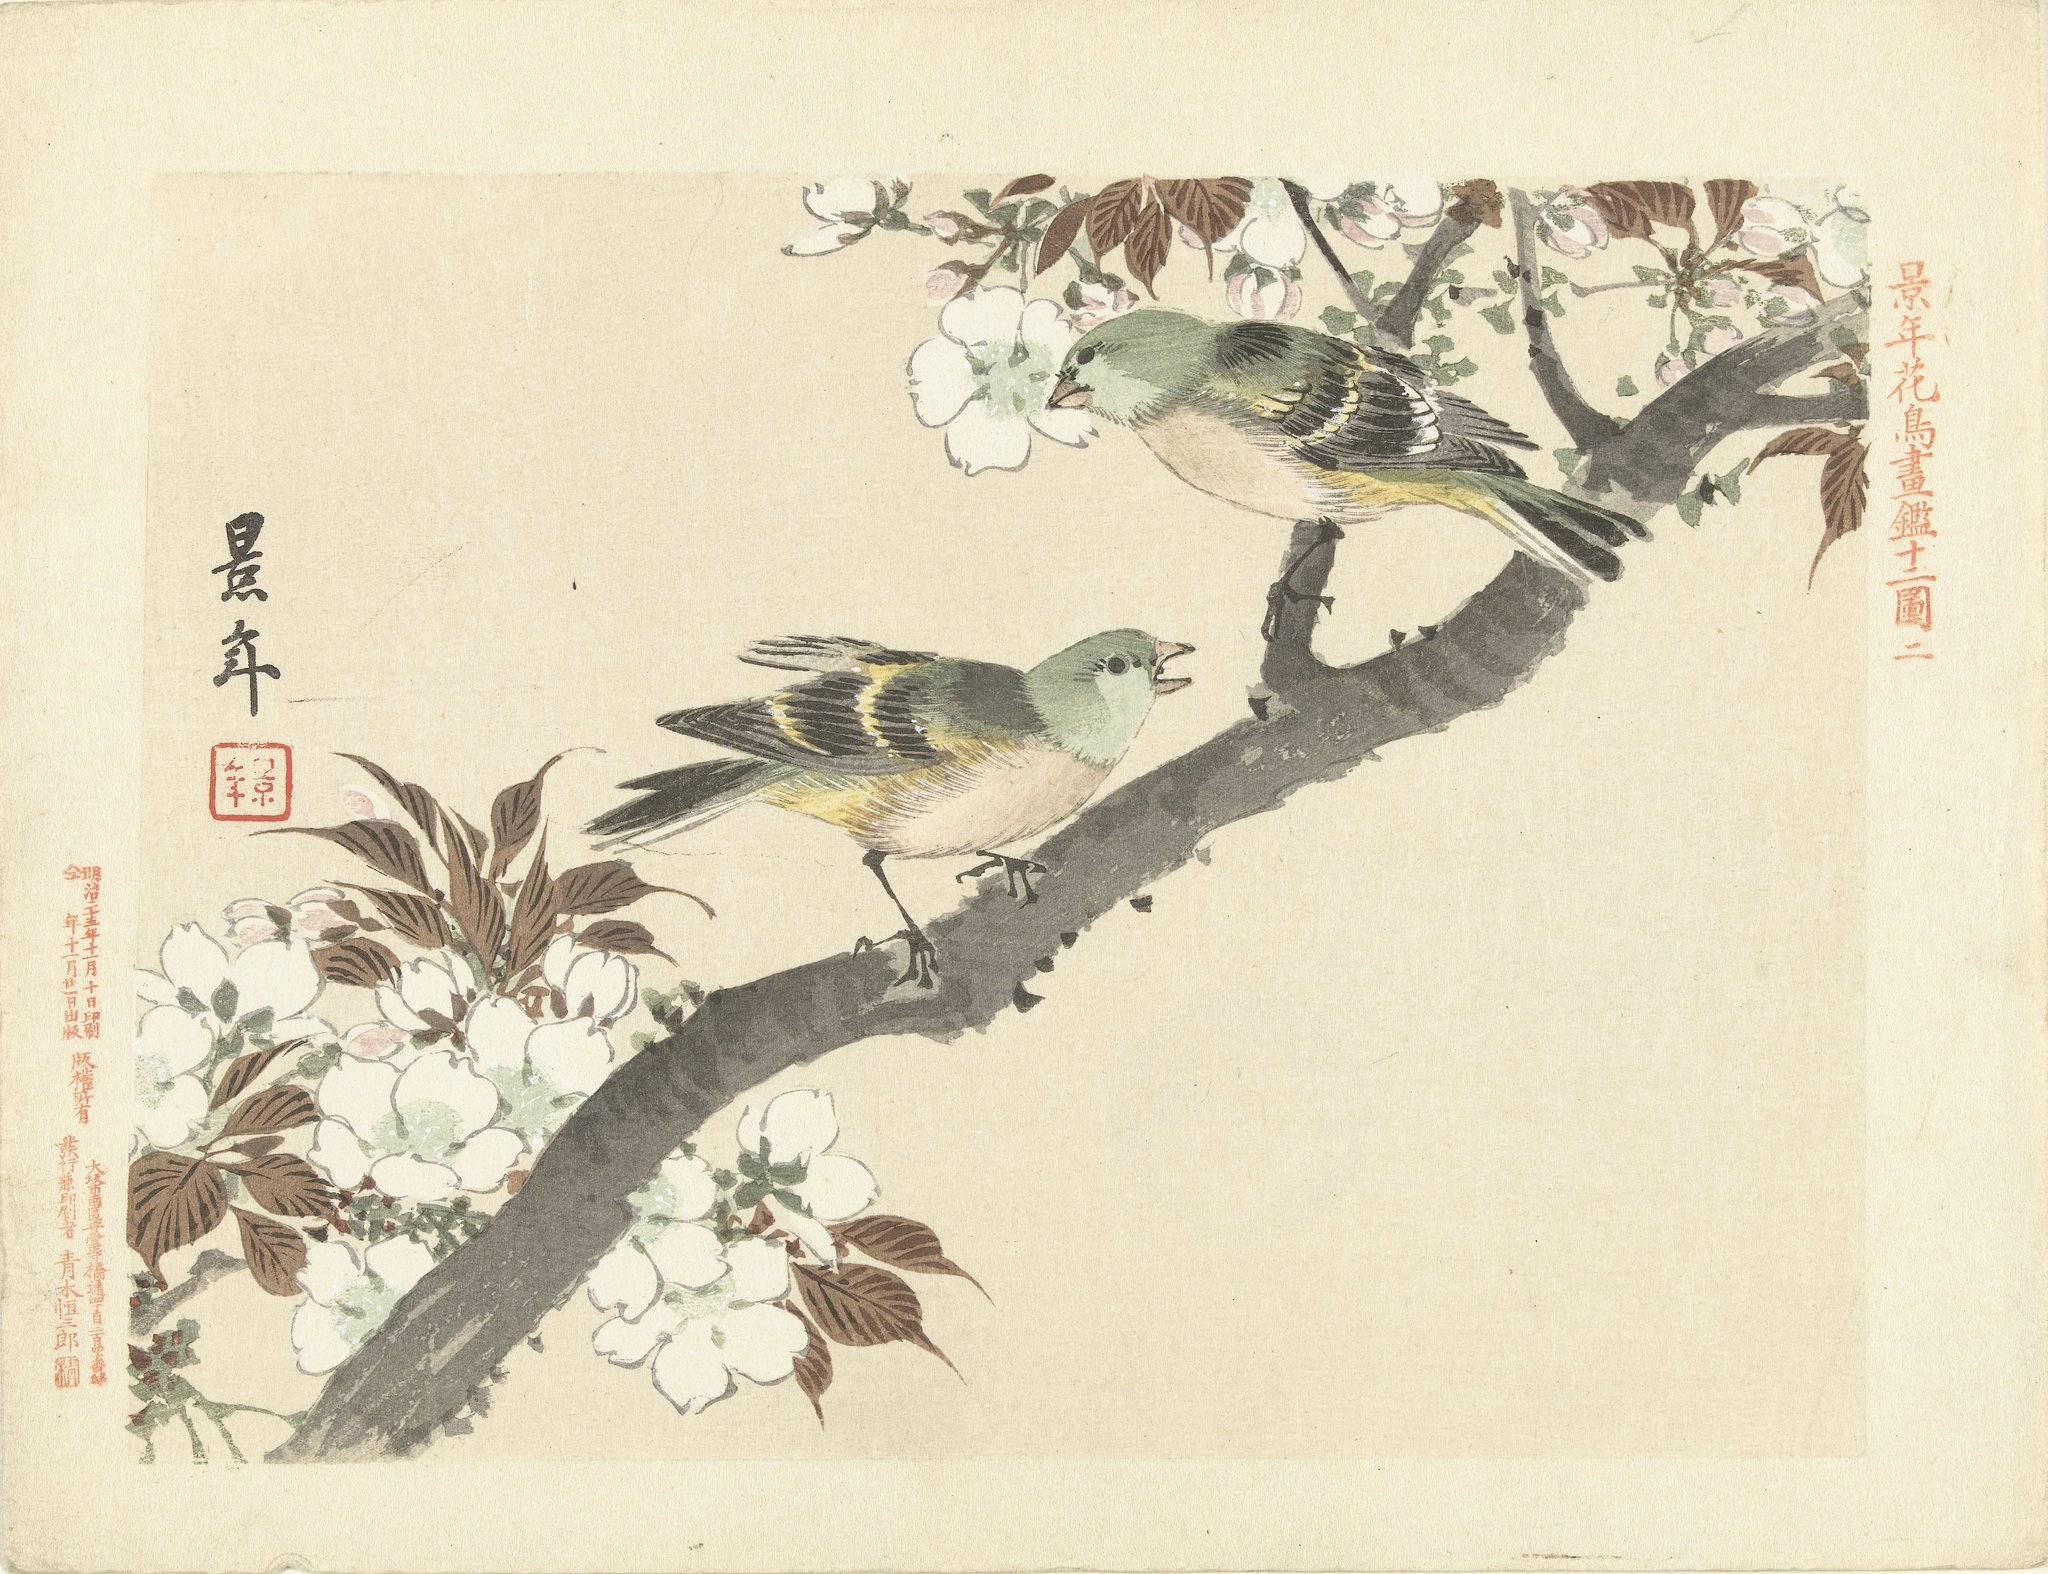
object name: print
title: Keinen kacho gafu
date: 1811-1892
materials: paper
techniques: woodcut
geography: osaka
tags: plants; vegetation, birds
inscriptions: collector's mark: Lugt 2228, collector's mark: ‘Rijksschool voor kunstnijverheid’ Lugt 3937